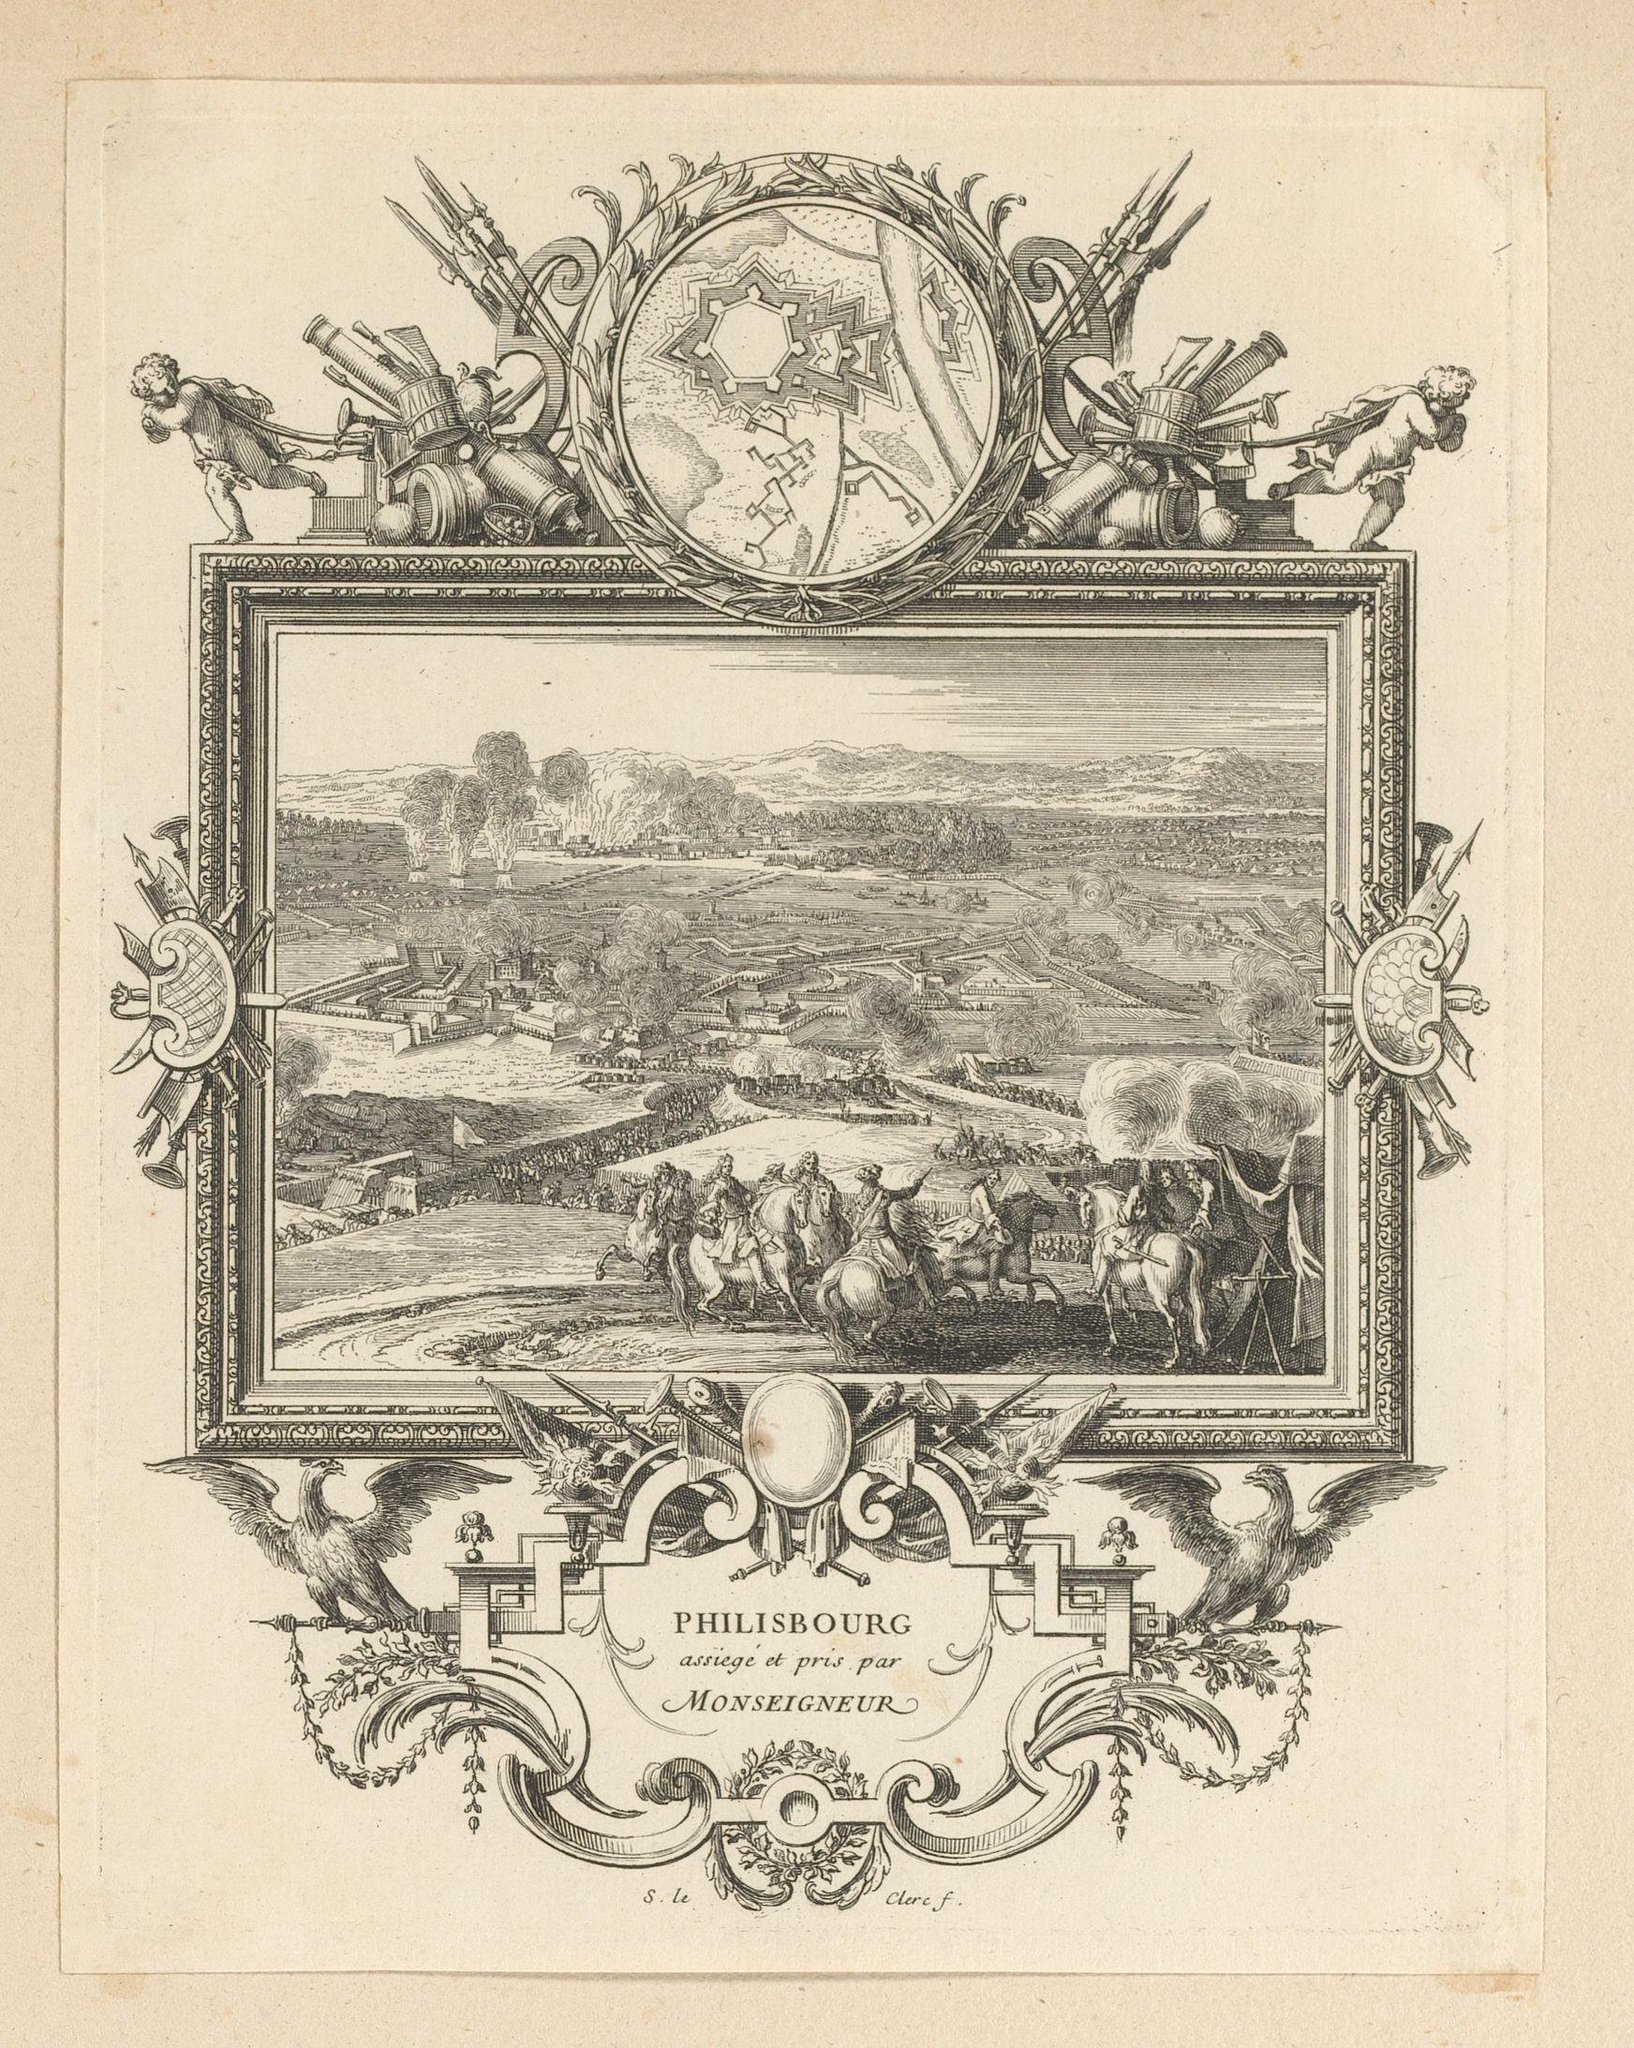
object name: album leaf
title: Histoire de Charles V duc de Lorraine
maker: sébastien leclerc (i)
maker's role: print maker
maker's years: 1637-1714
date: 1704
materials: paper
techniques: etching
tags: historical persons, capture of city (after the siege)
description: Prent maakt deel uit van een serie van 37 prenten met veldslagen waar Karel V Leopold, hertog van Lotharingen, aan deelgenomen heeft.